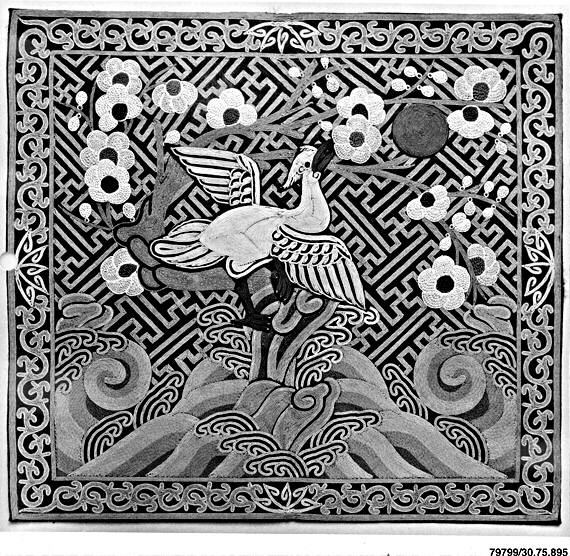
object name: woman's rank badge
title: Woman's Rank Badge with Egret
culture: chinese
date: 1801-1900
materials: silk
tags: birds